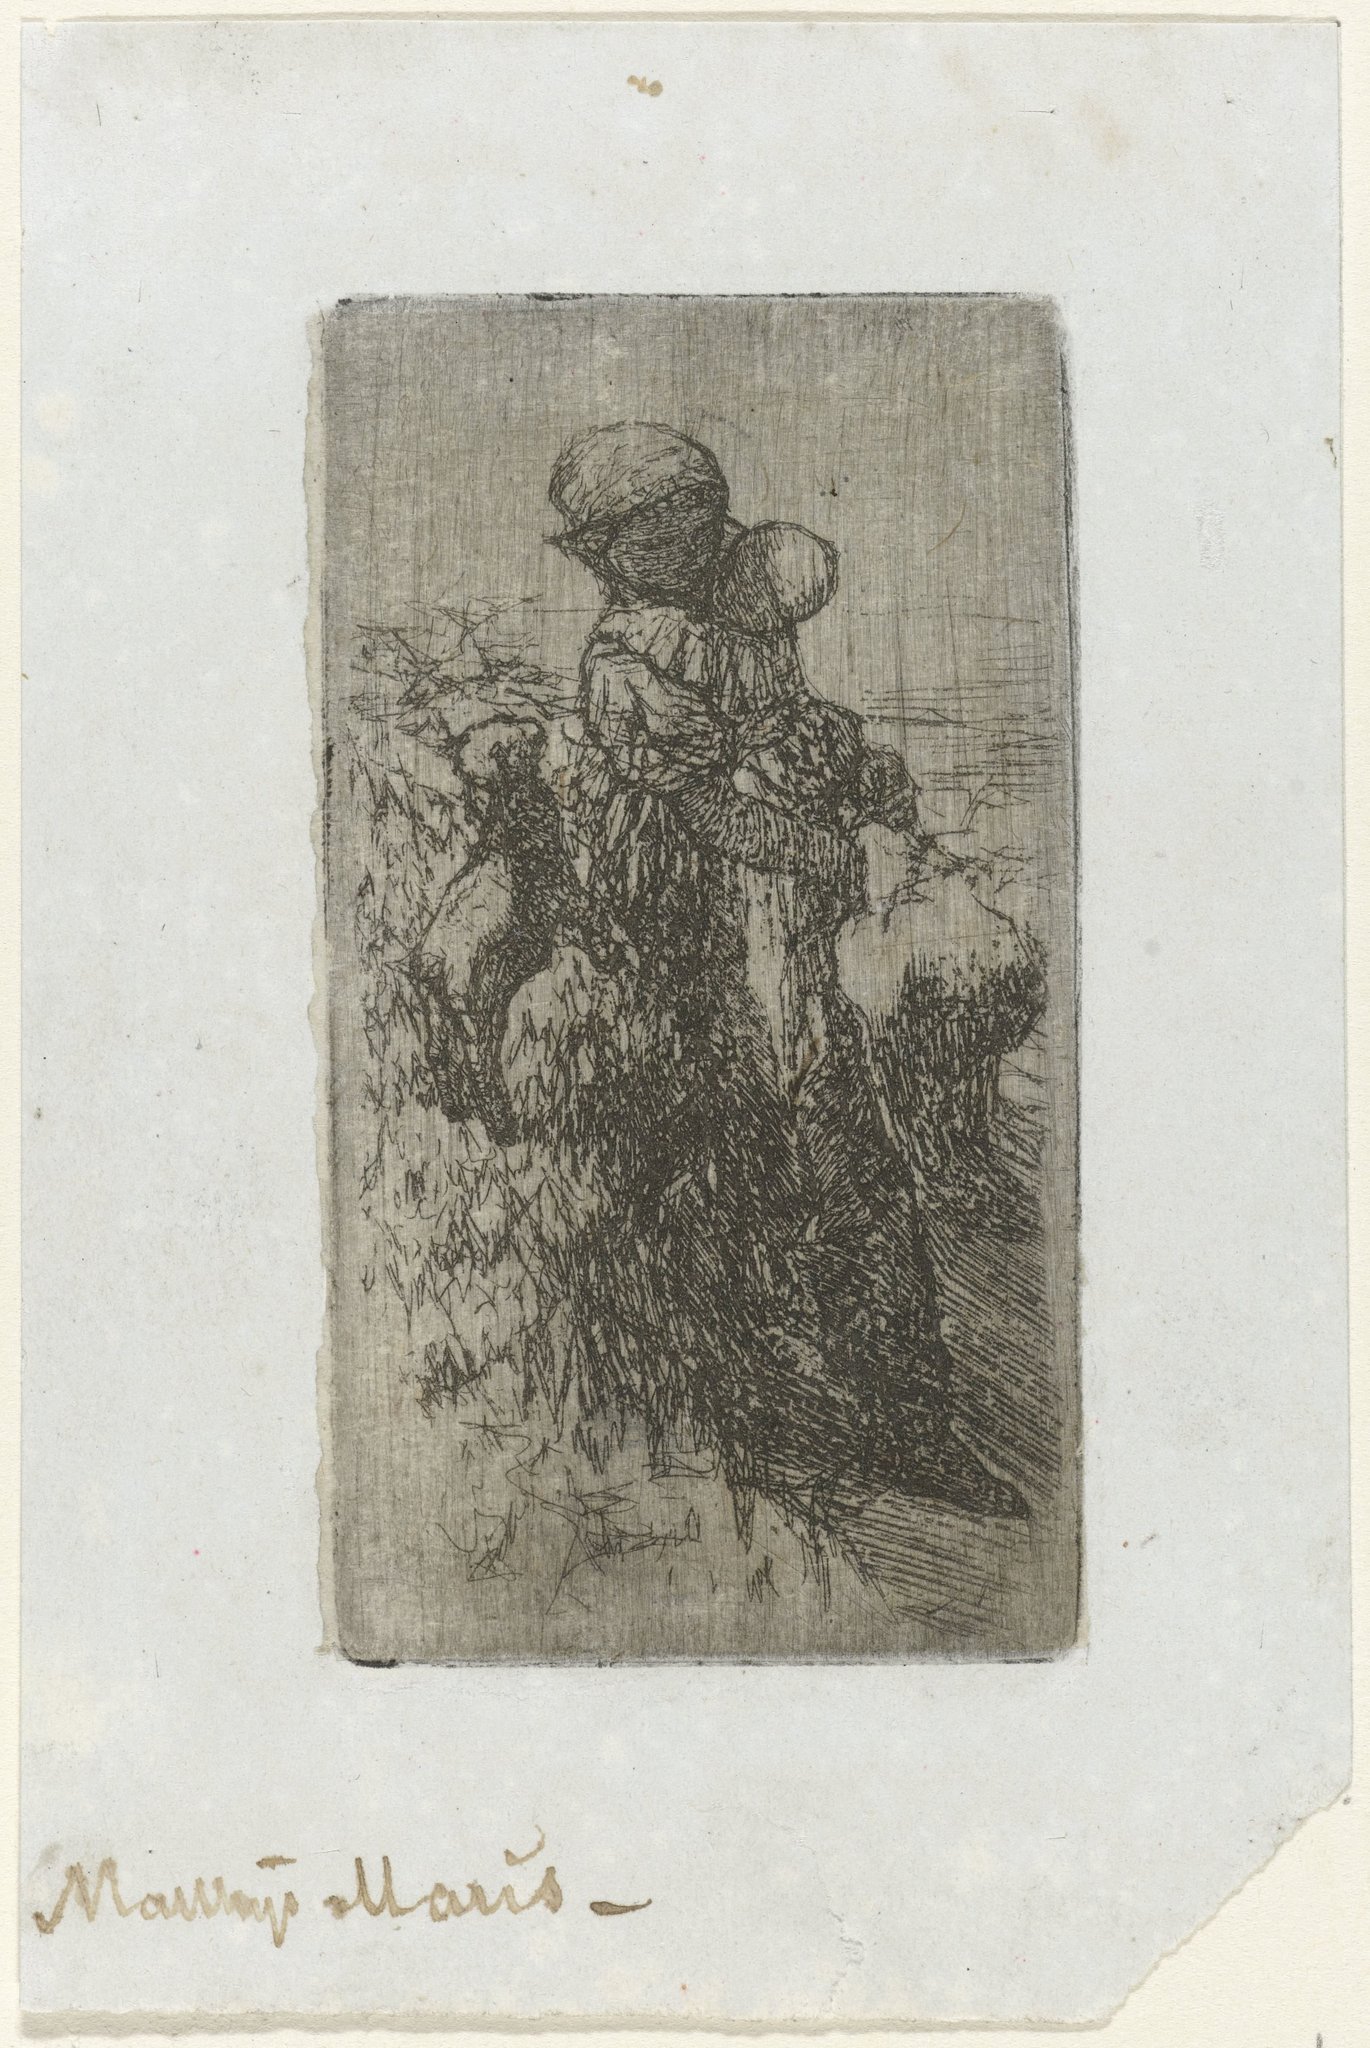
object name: print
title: Meisje met kind op de arm bij een lam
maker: matthijs maris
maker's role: draughtsman, painter, print maker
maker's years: 1839-1917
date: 1851-1855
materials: paper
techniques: etching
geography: the hague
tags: youth, adolescent (+ young female (human being)), lamb, infant, baby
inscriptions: collector's mark: Lugt 2228, collector's mark: Lugt 2676a, name: ‘Matthijs Maris’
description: Op opzetblad etiket met: 3201 inventaris A. Misschien verwijst het nummer naar de veiling van de collectie van Zilcken in 1902, 13-15 mei, Den Haag (dir. Martinus Nijhoff et R. W. P. de Vries).